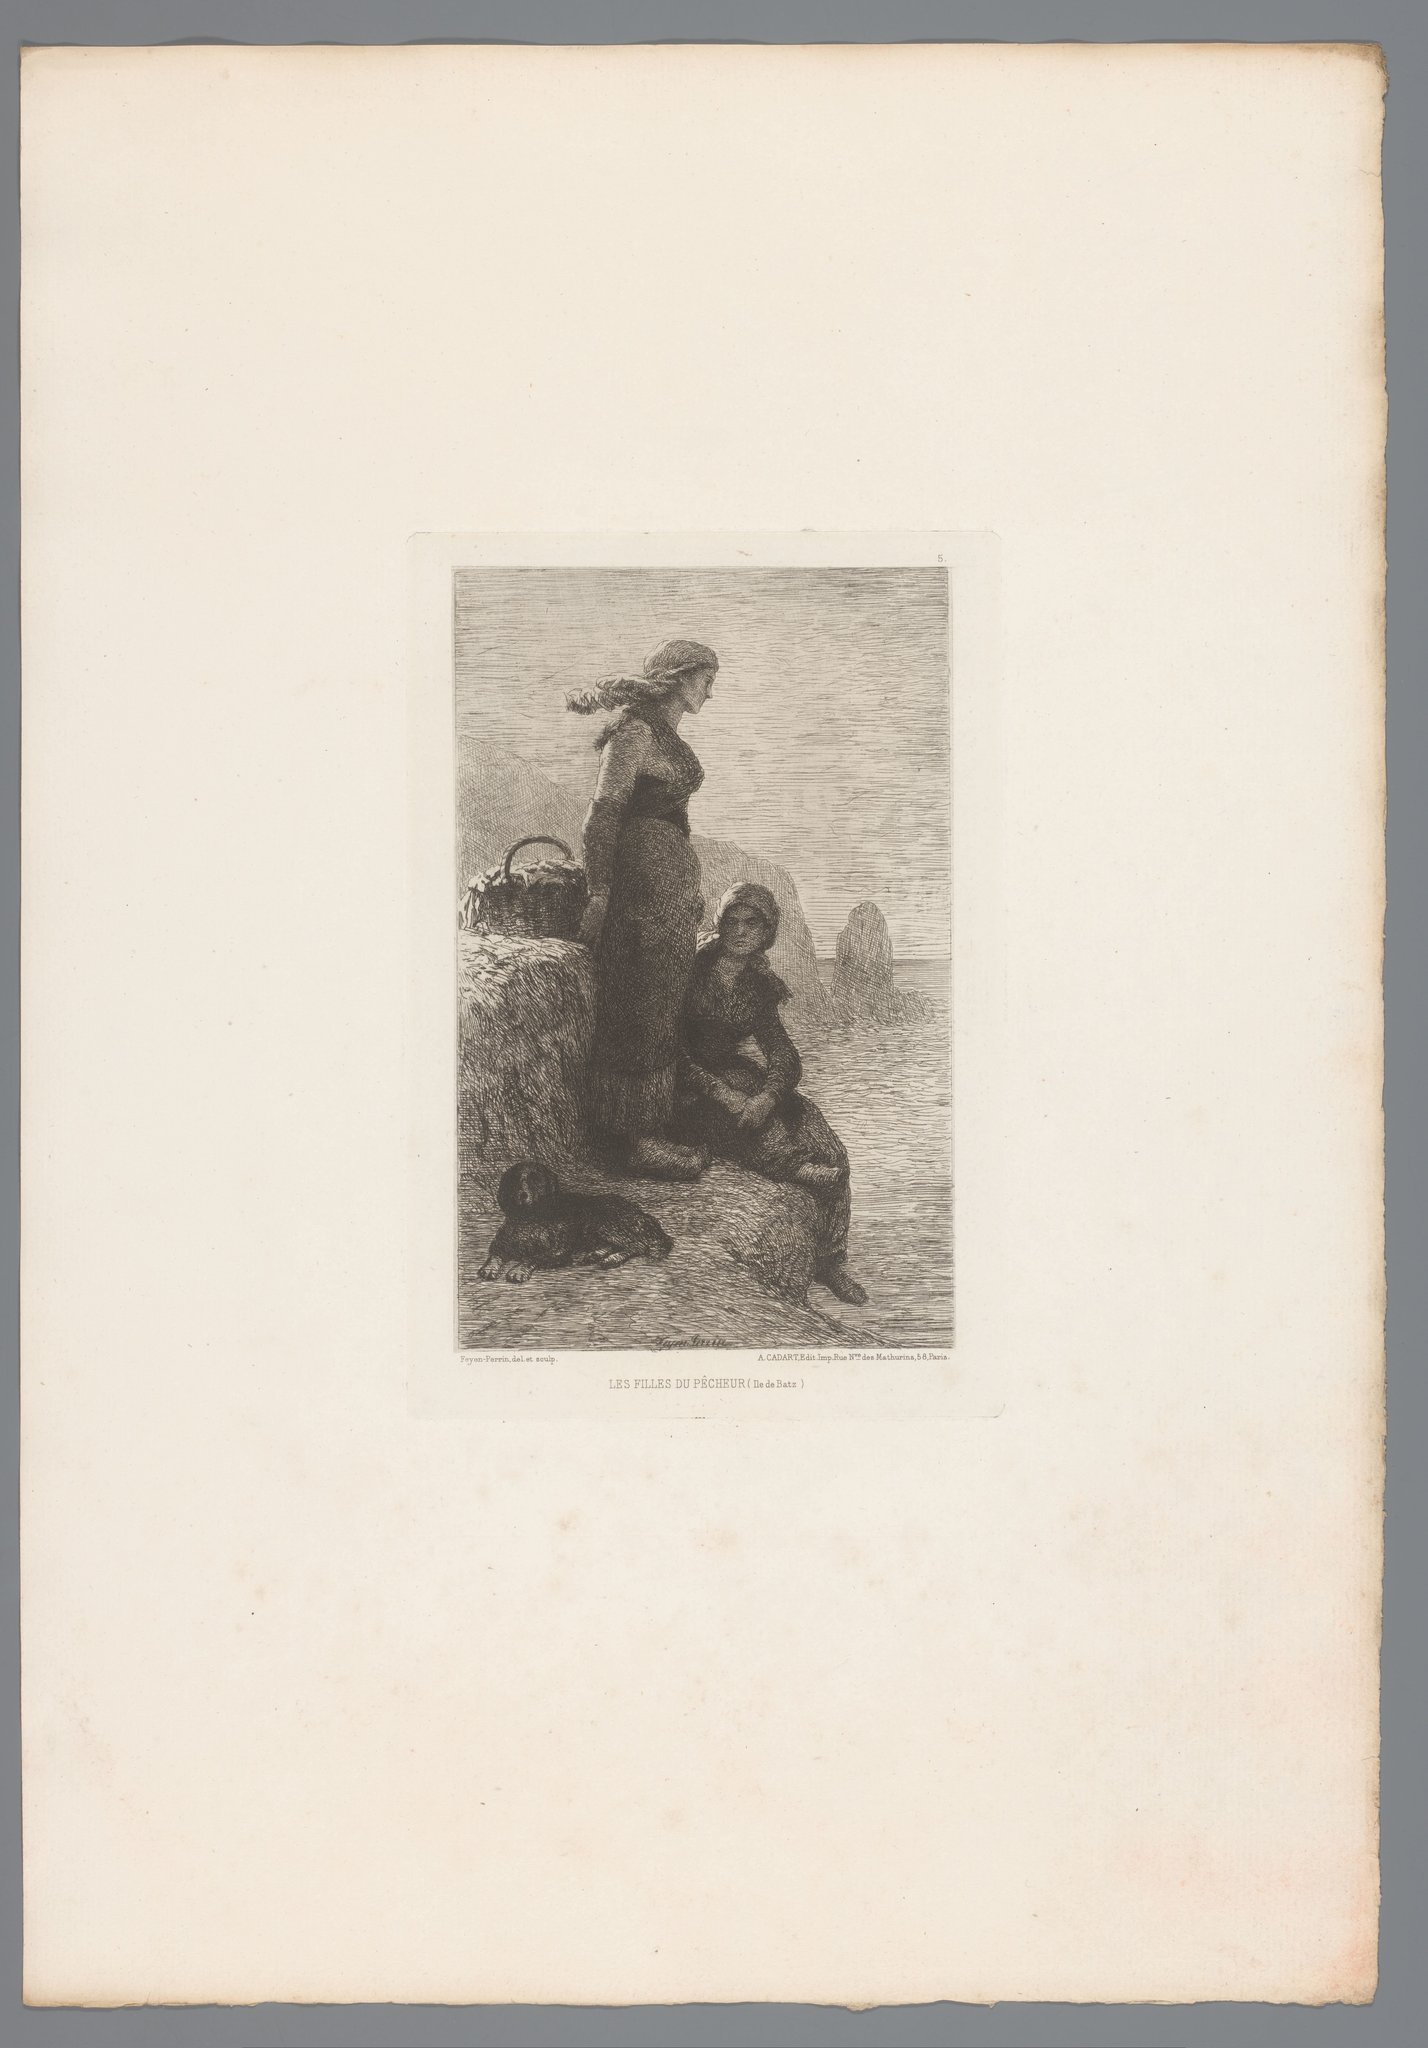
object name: print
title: Twee jonge vissersvrouwen en hun hond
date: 1874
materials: paper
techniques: drypoint, etching, intaglio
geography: paris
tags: adolescent, young woman, maiden, fisherman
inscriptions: watermark, collector's mark: Lugt 2760, collector's mark: Lugt 2228, collector's mark: ‘AFE v S’ Lugt